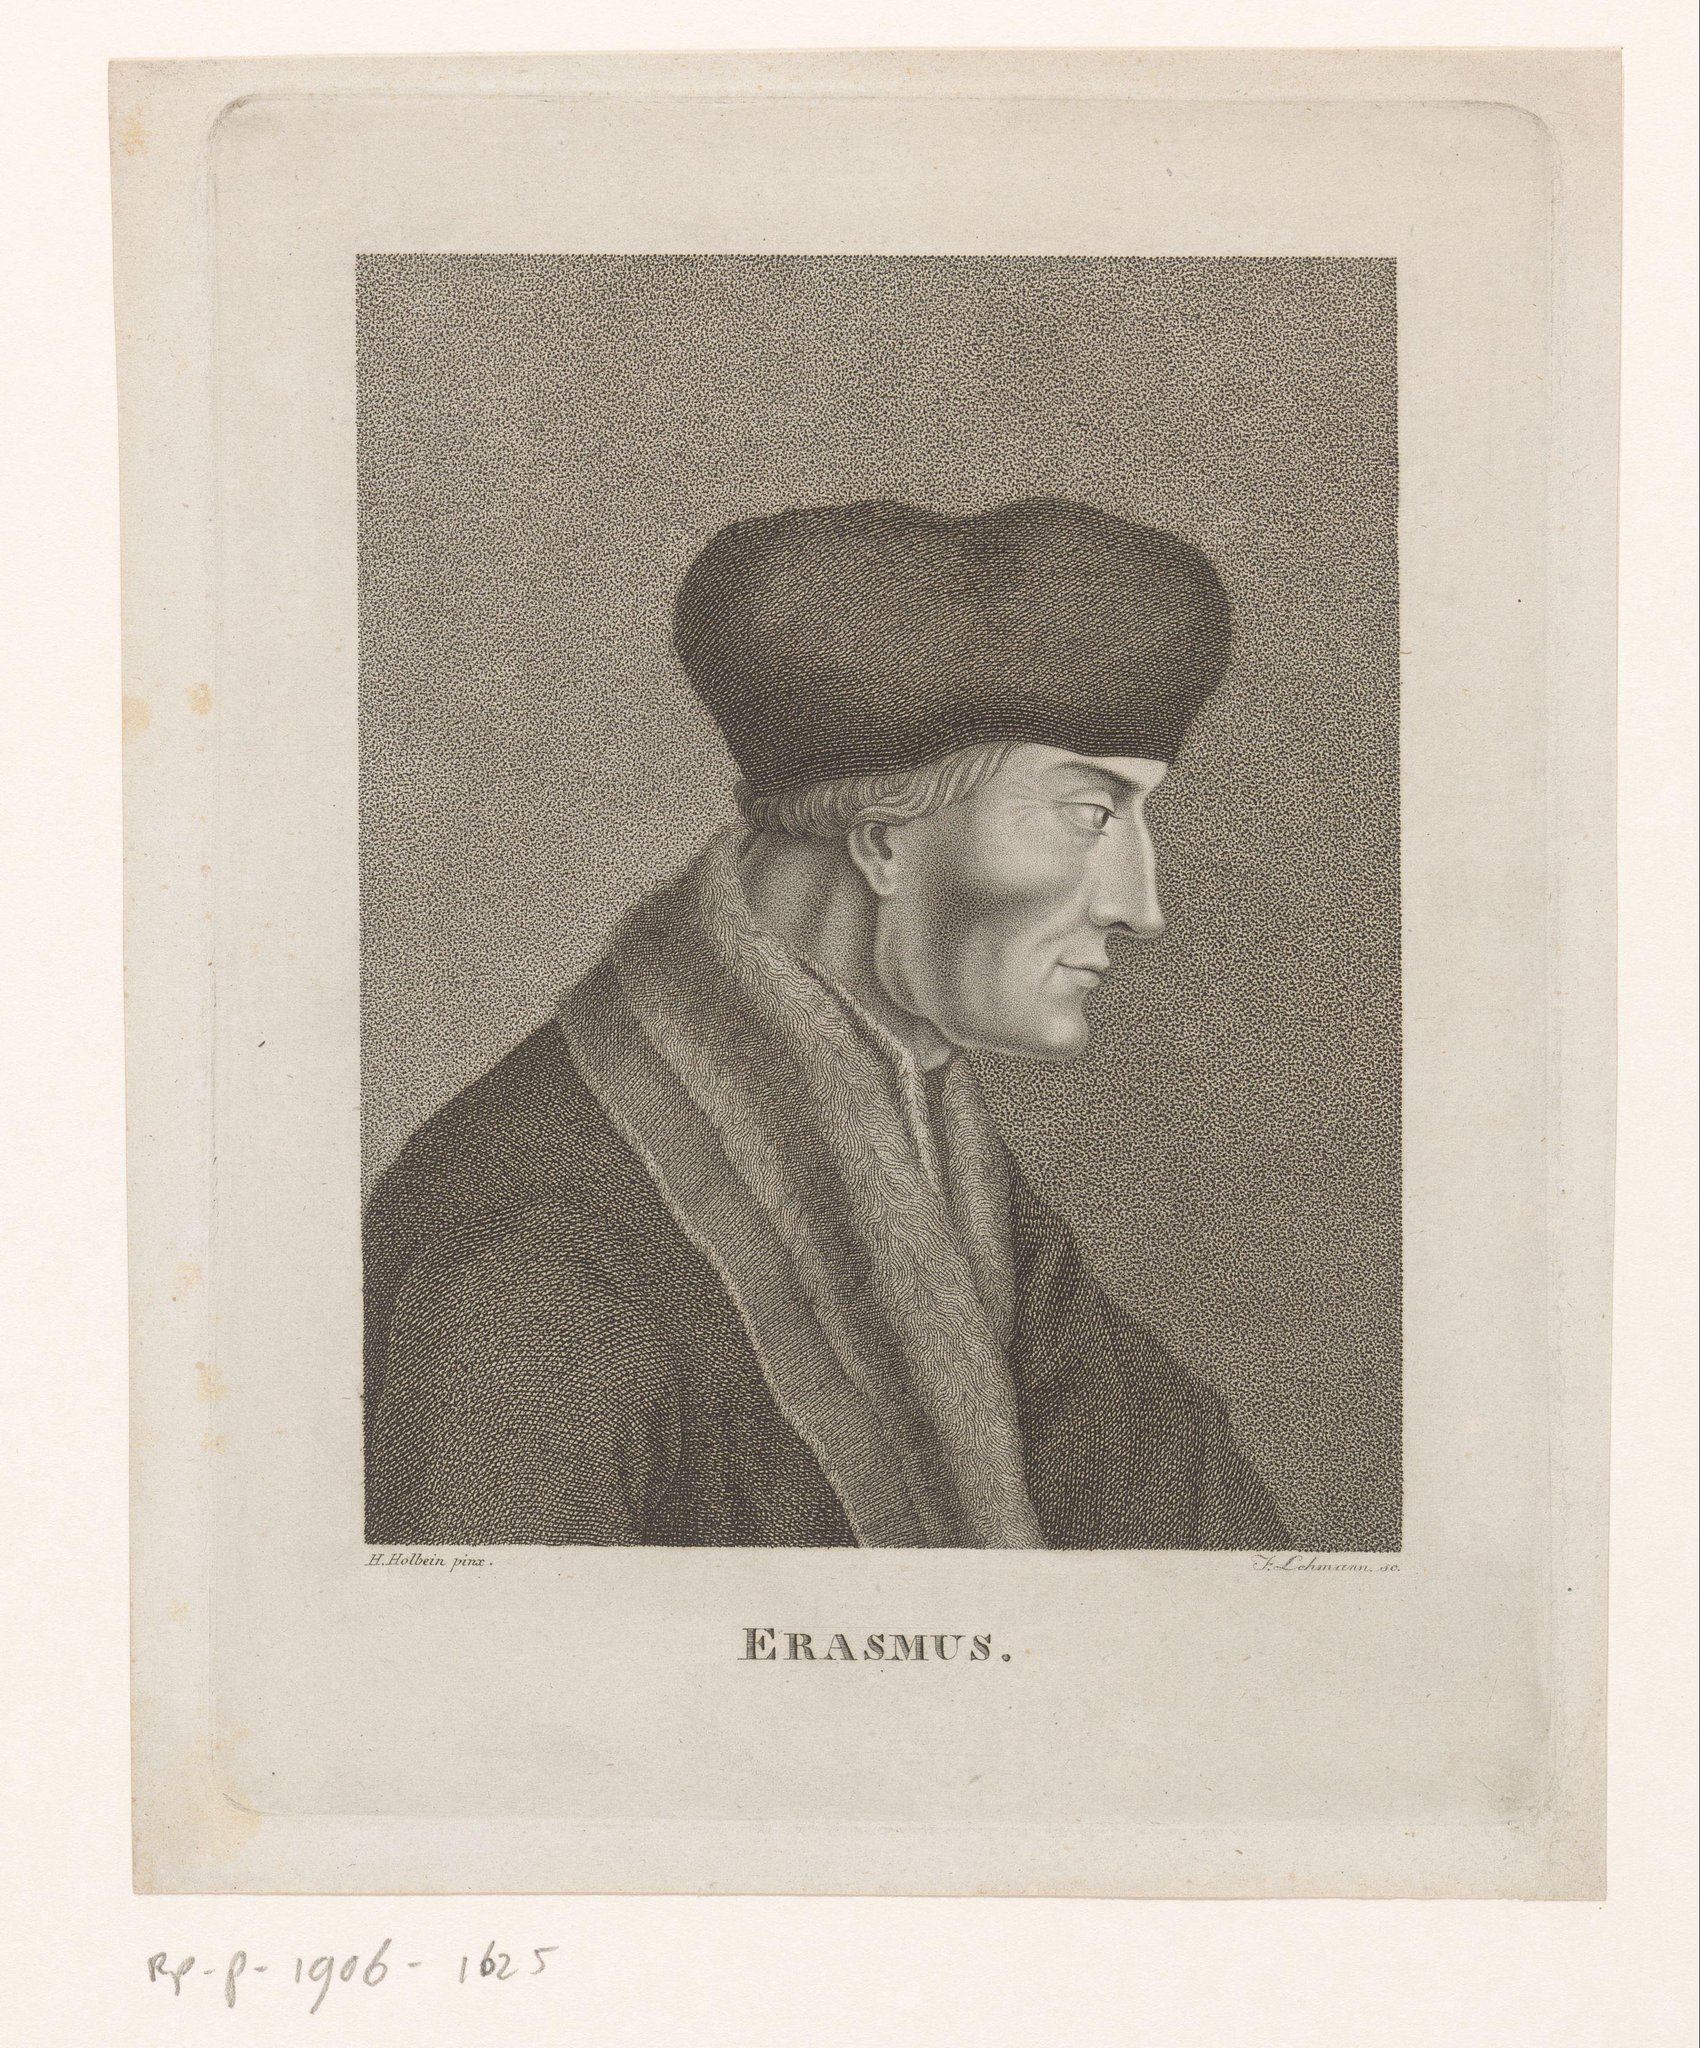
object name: print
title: Portret van Desiderius Erasmus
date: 1797-1886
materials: paper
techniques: engraving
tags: rotterdam, desiderius erasmus, historical persons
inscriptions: collector's mark: Lugt 2228